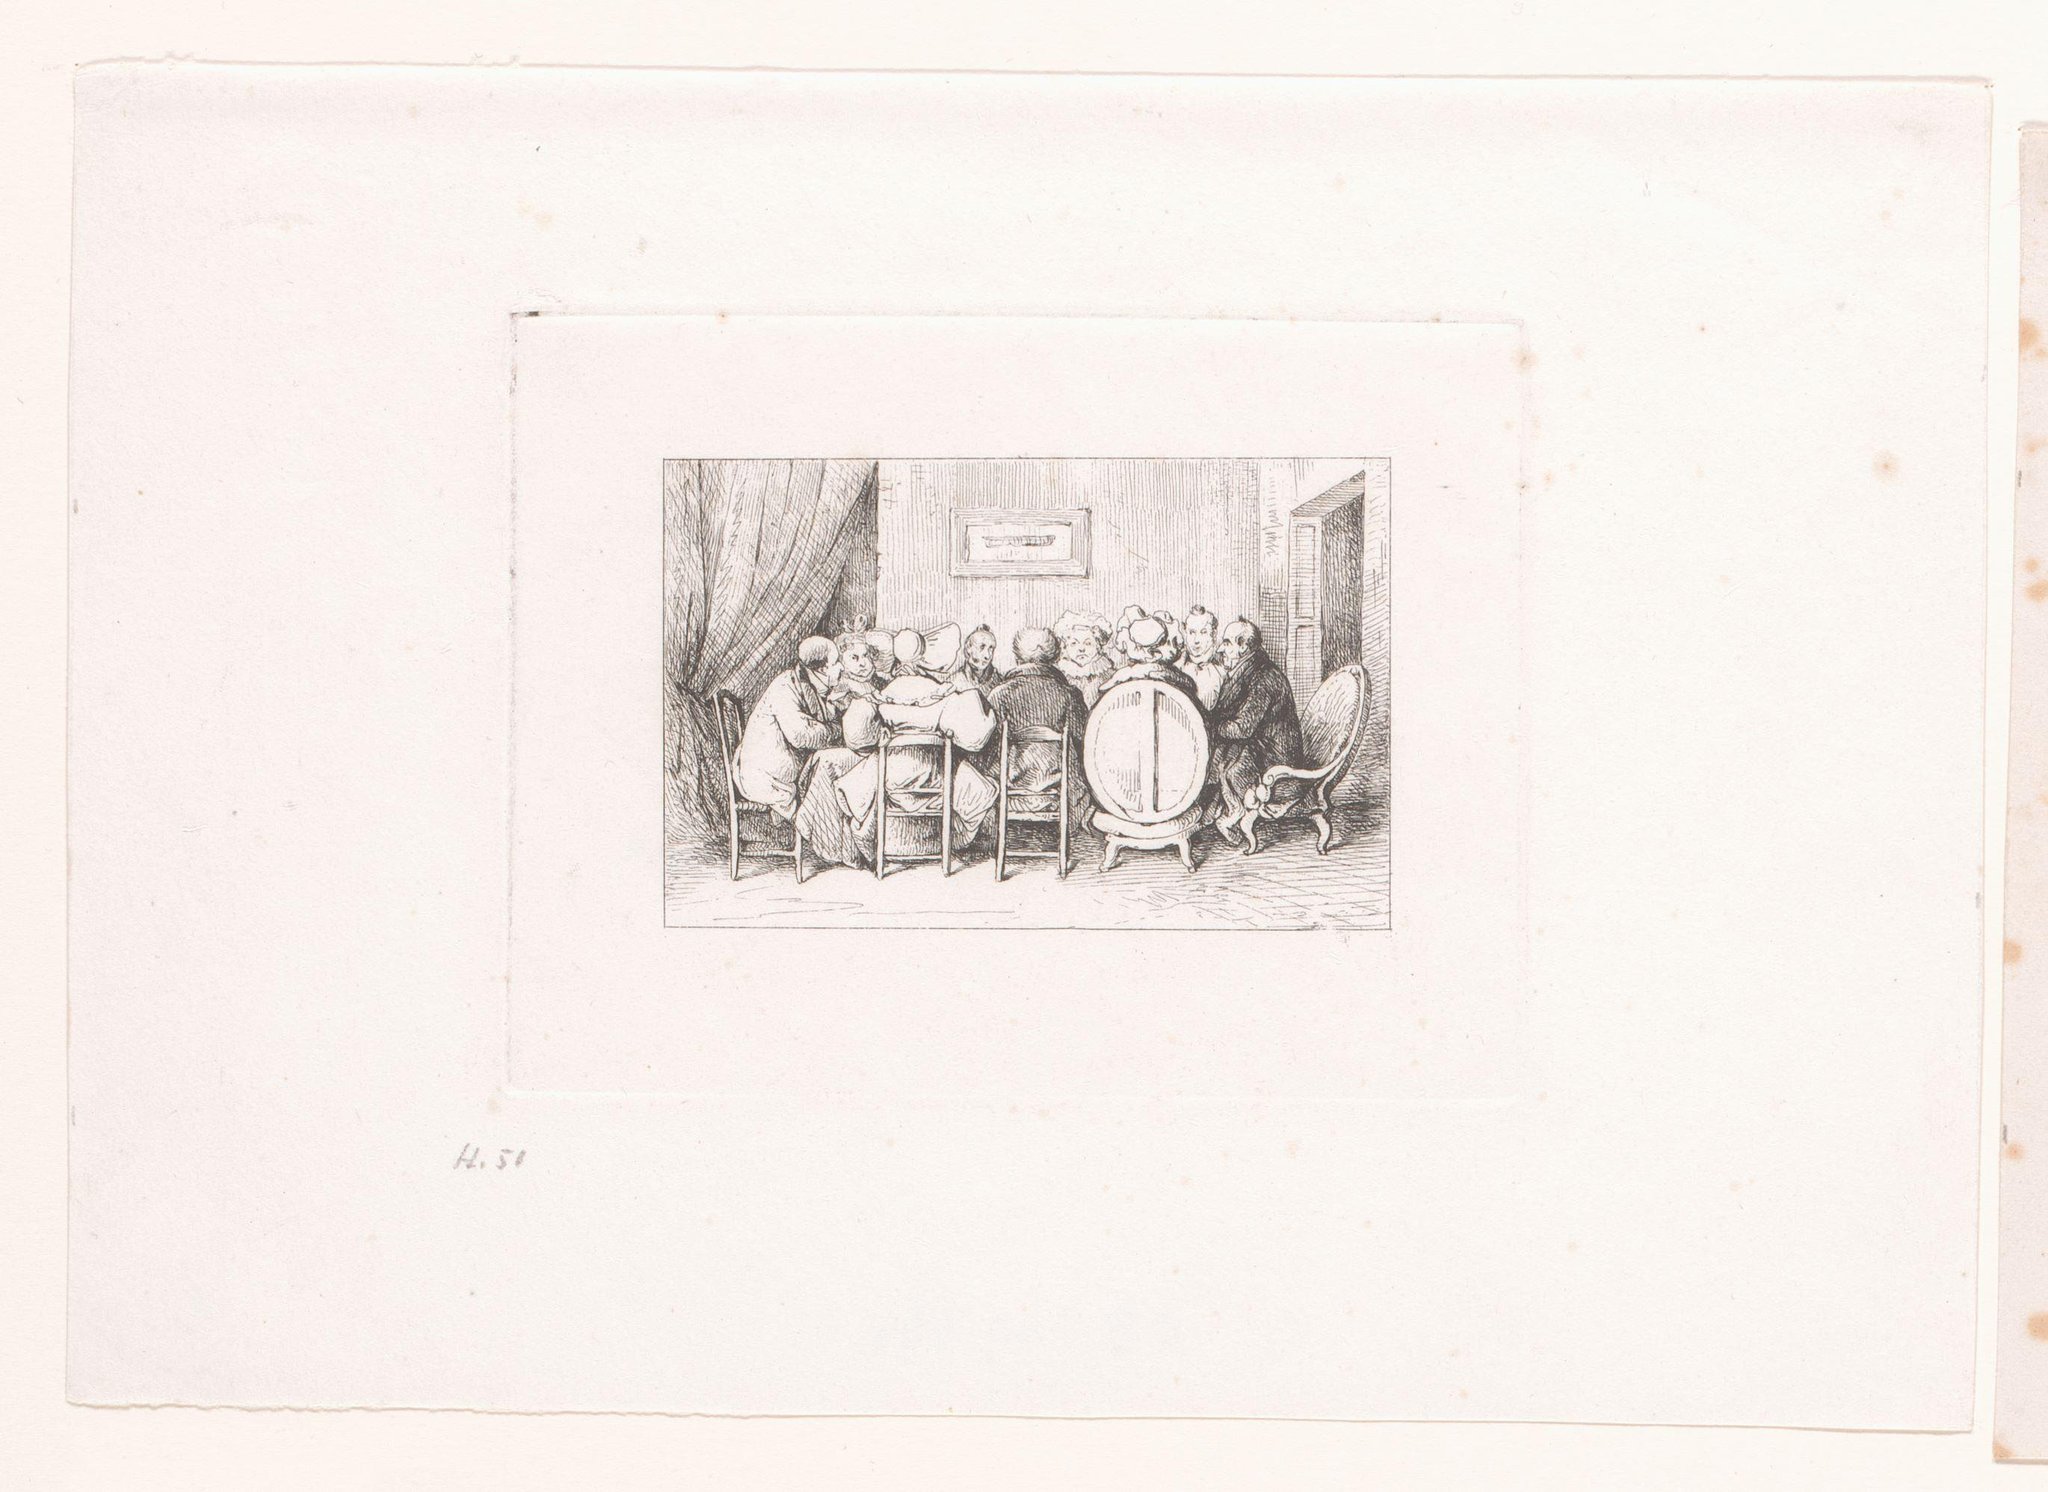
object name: book illustration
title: Groep mensen aan het diner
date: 1830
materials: paper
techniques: etching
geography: paris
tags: evening meal, dinner, supper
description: Prent uit: Monnier, Henry. Scènes populaires, dessinées à la plume. Parijs: Levavasseur, 1830.